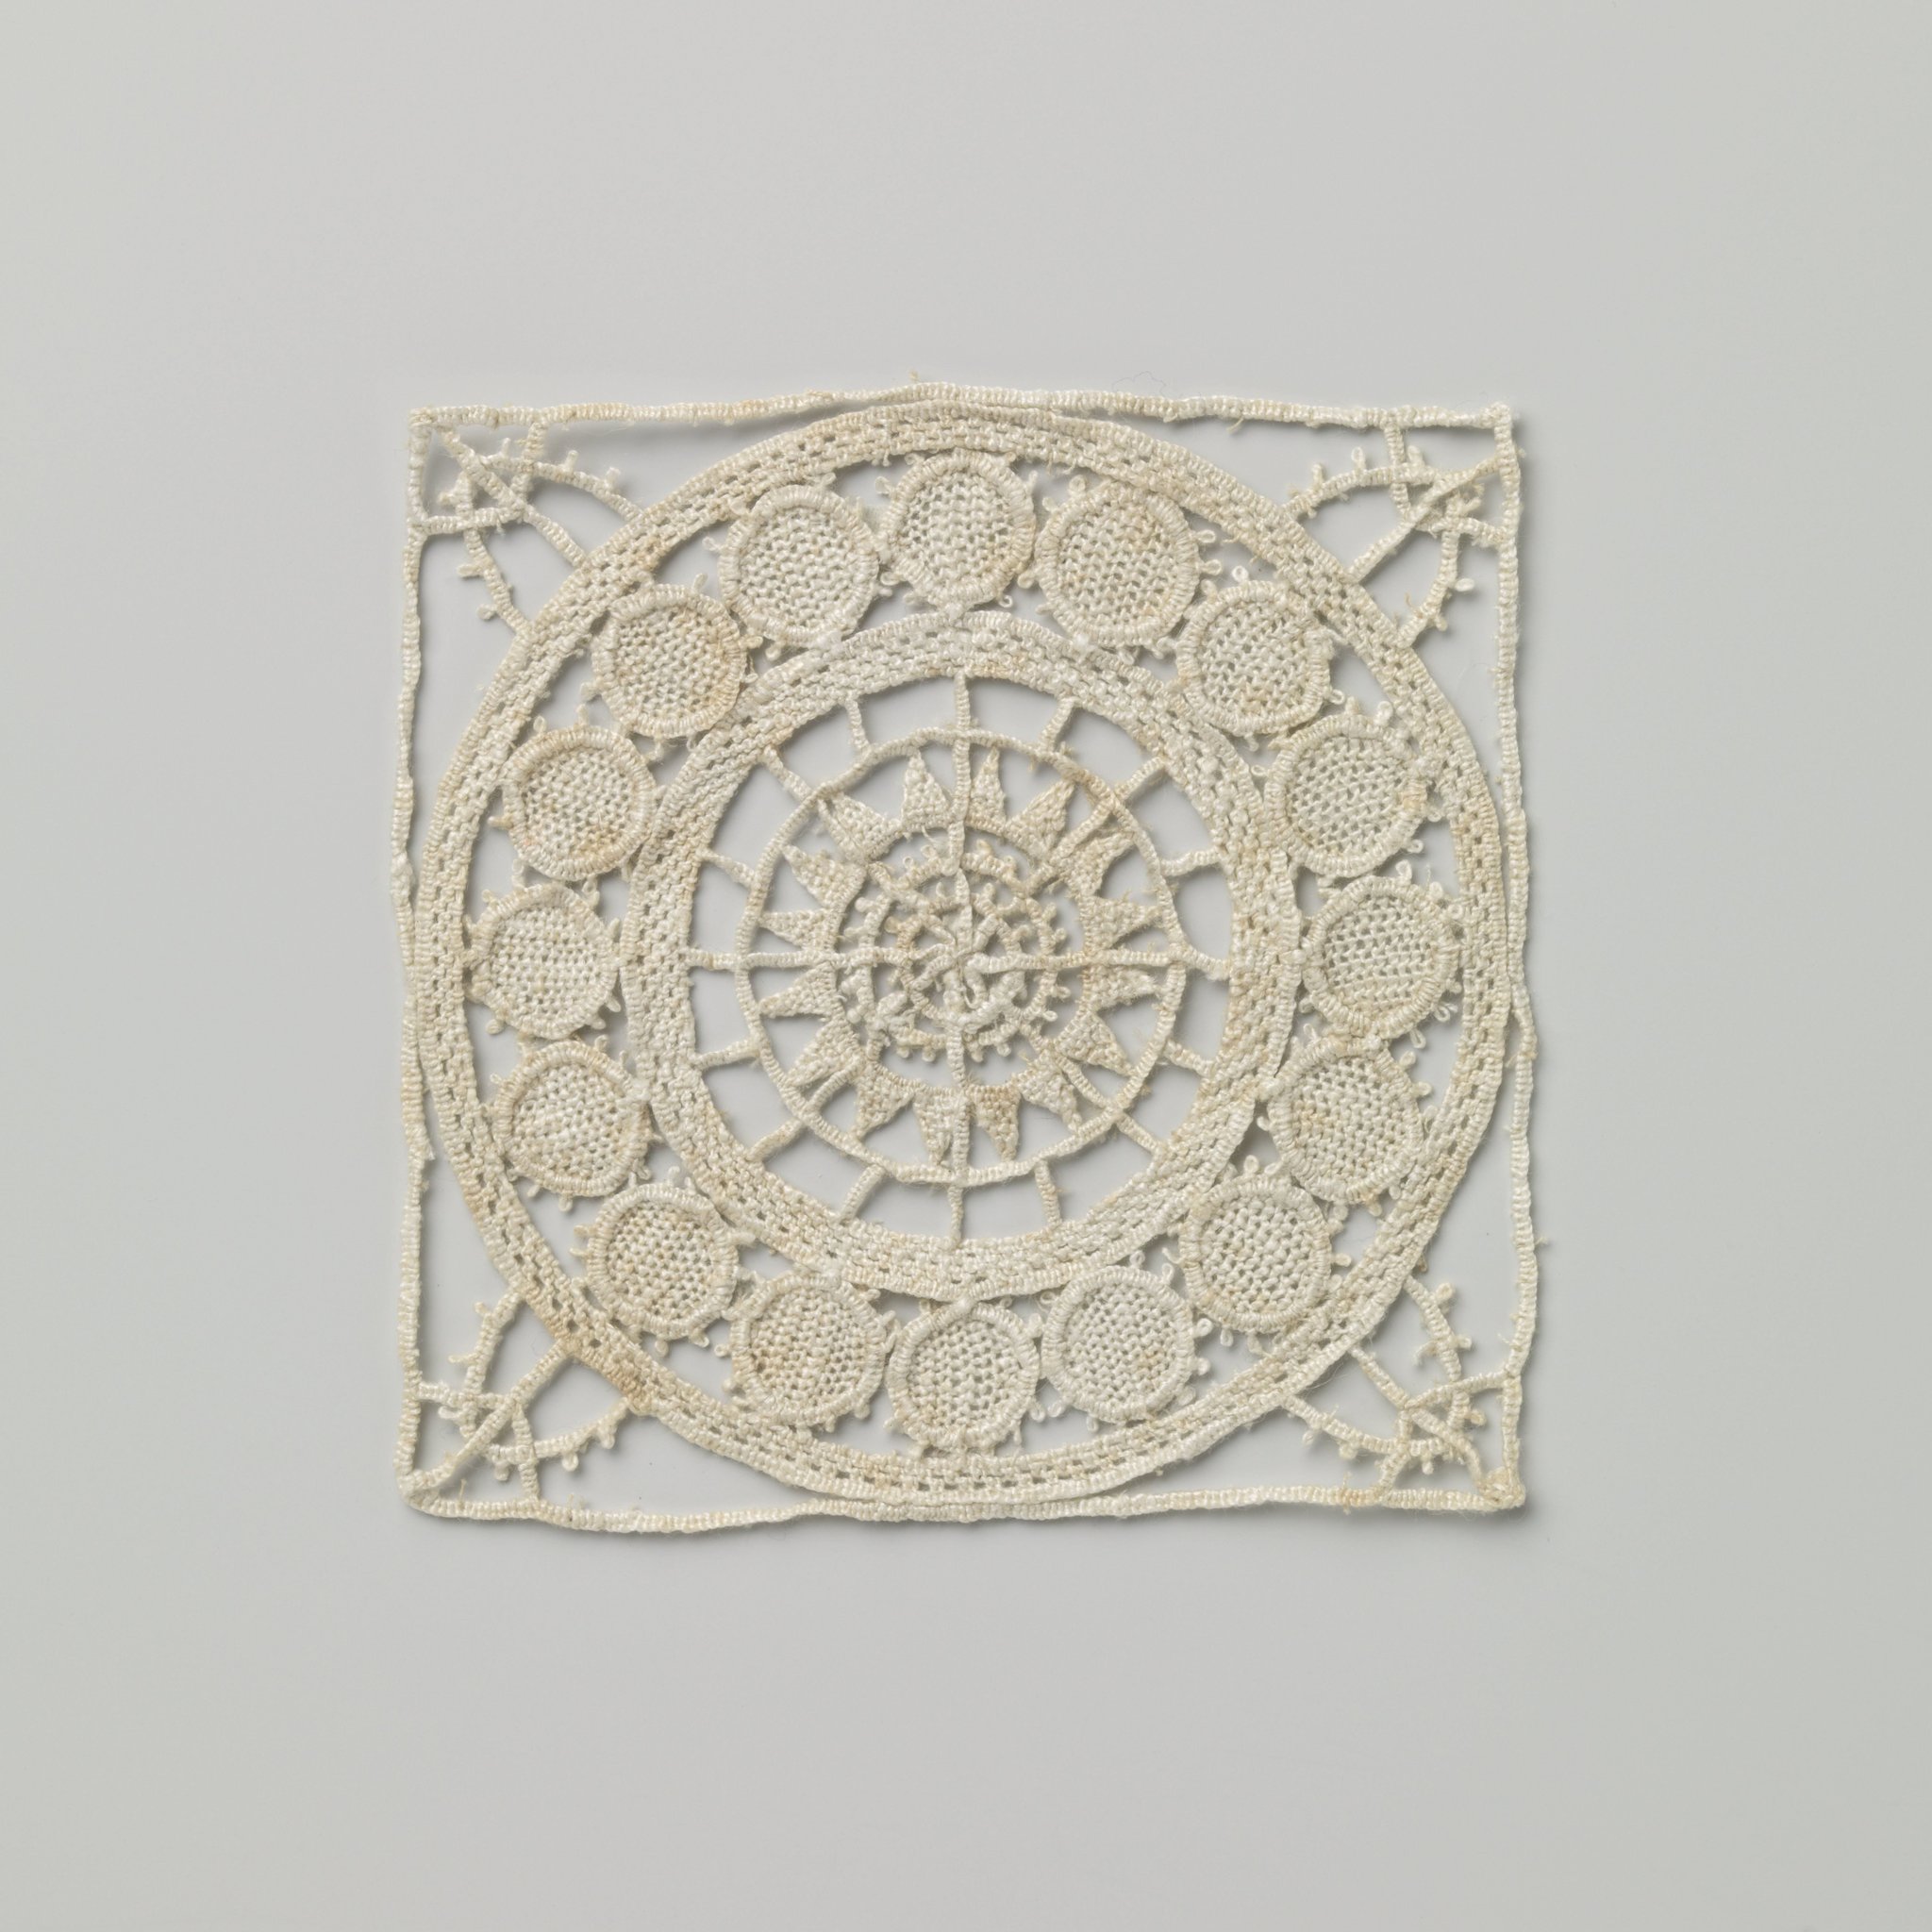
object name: werkstuk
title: Werkstuk kantborduurwerk met zonmedaillon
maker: geesje smid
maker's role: artisan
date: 1890-1899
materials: linen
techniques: lace embroidery, reticella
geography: netherlands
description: Werkstuk voor het 'diploma fraaie handwerken'. Vierkantje reticella met zonmedaillon.